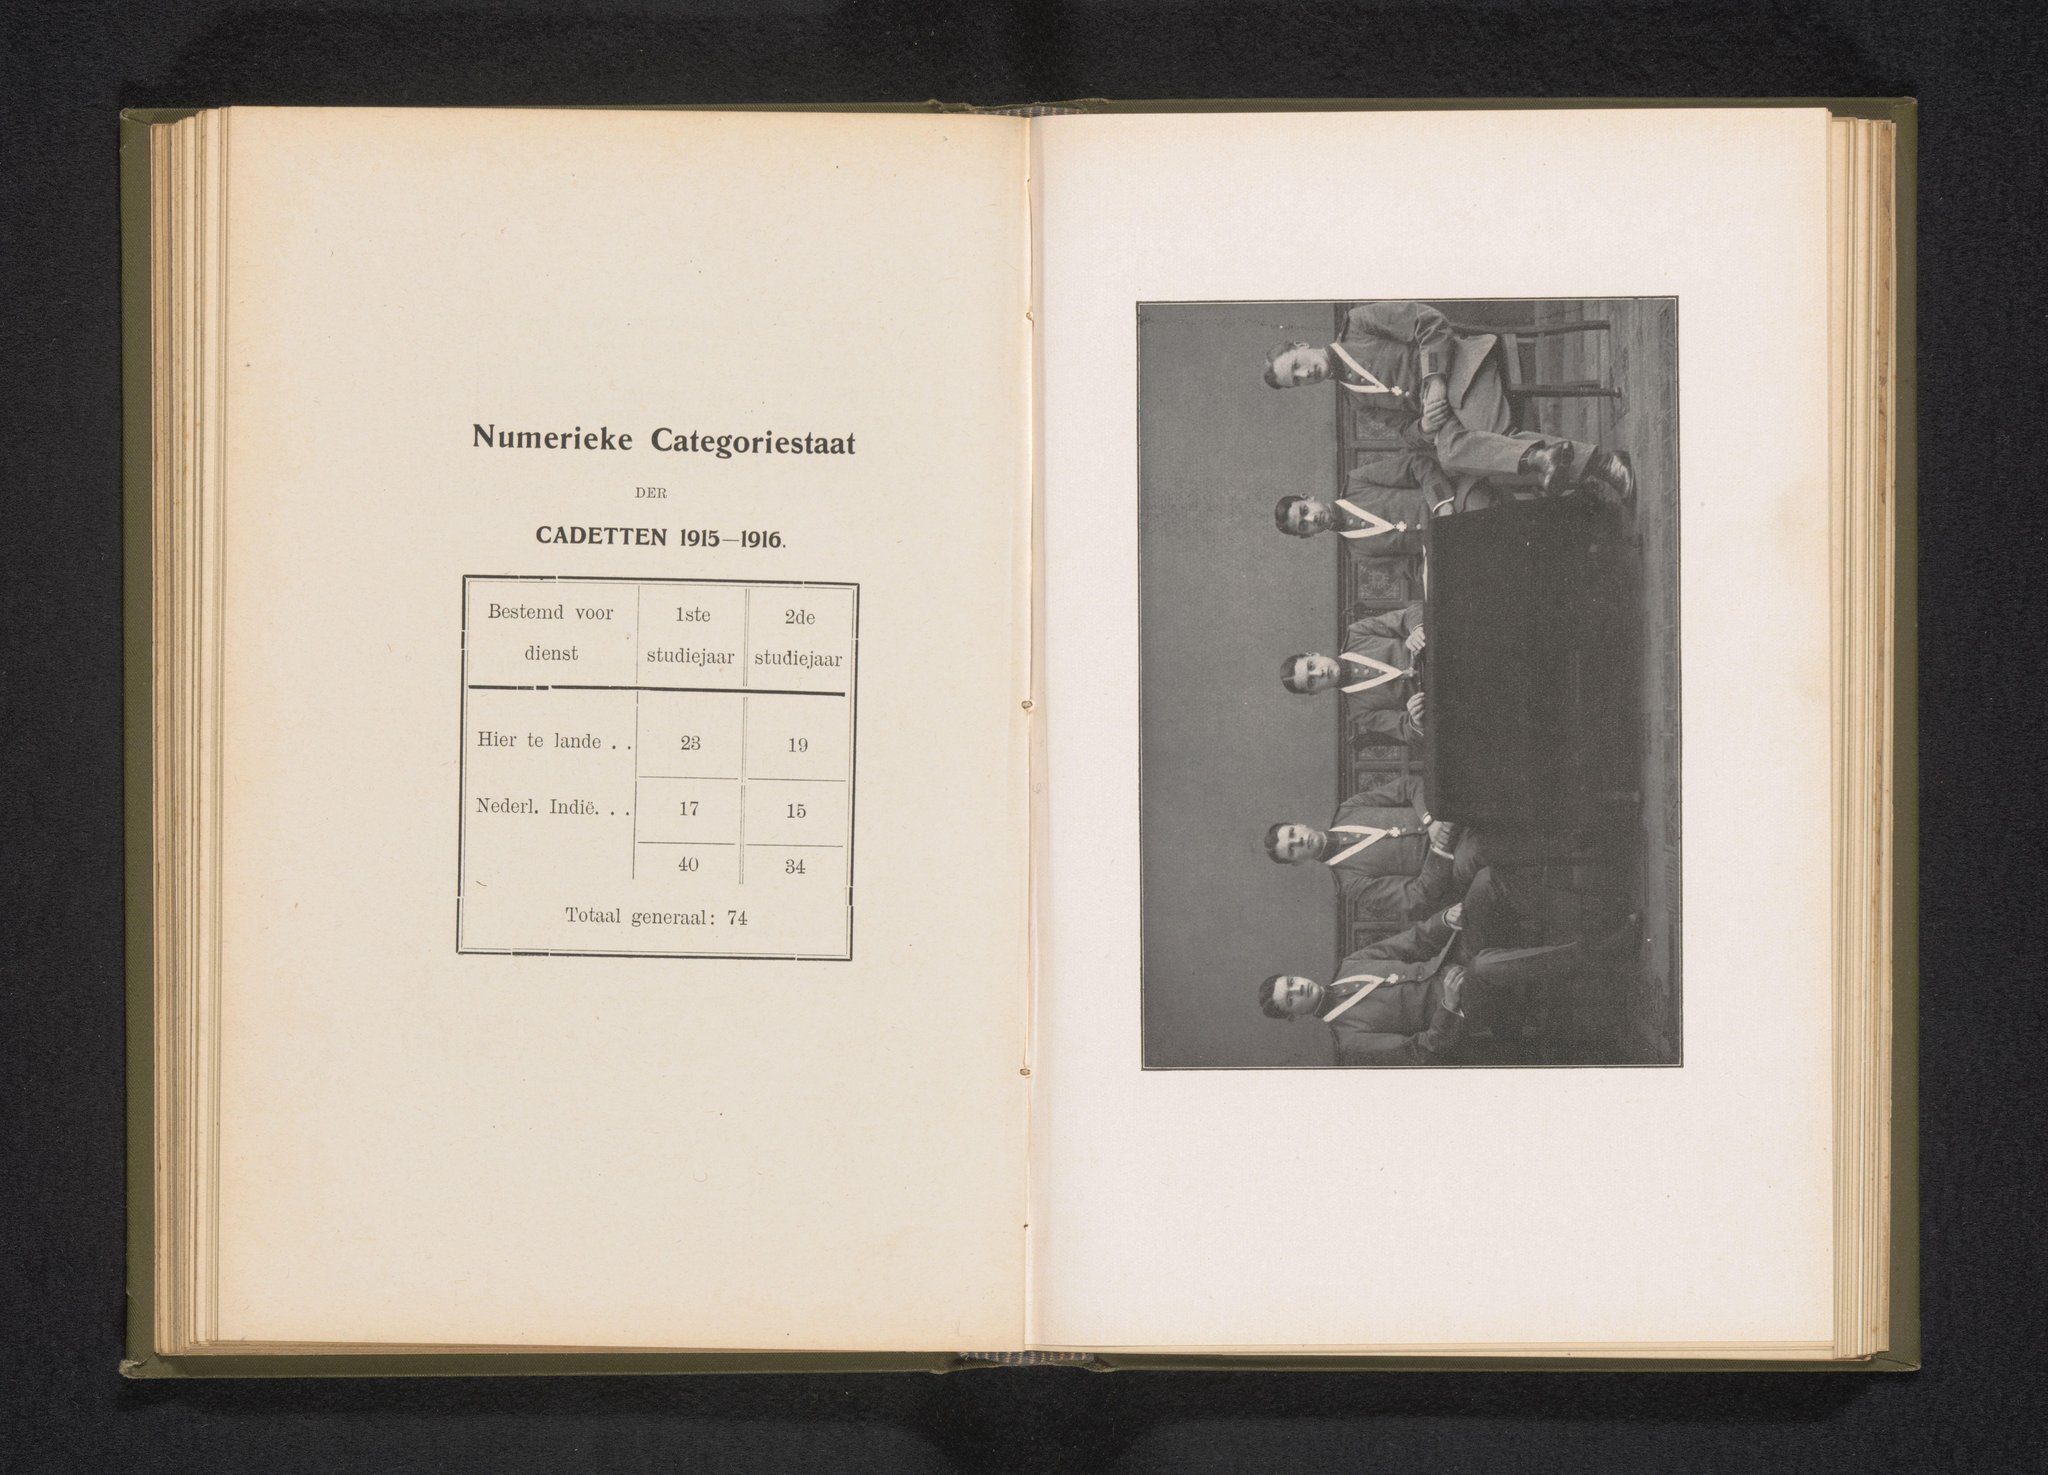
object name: page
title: Groepsportret van de Senaat van het Alkmaarsche Cadettenkorps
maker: Anonymous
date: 1911-1916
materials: paper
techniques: autotype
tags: anonymous historical persons portrayed in a group, in a group-portrait